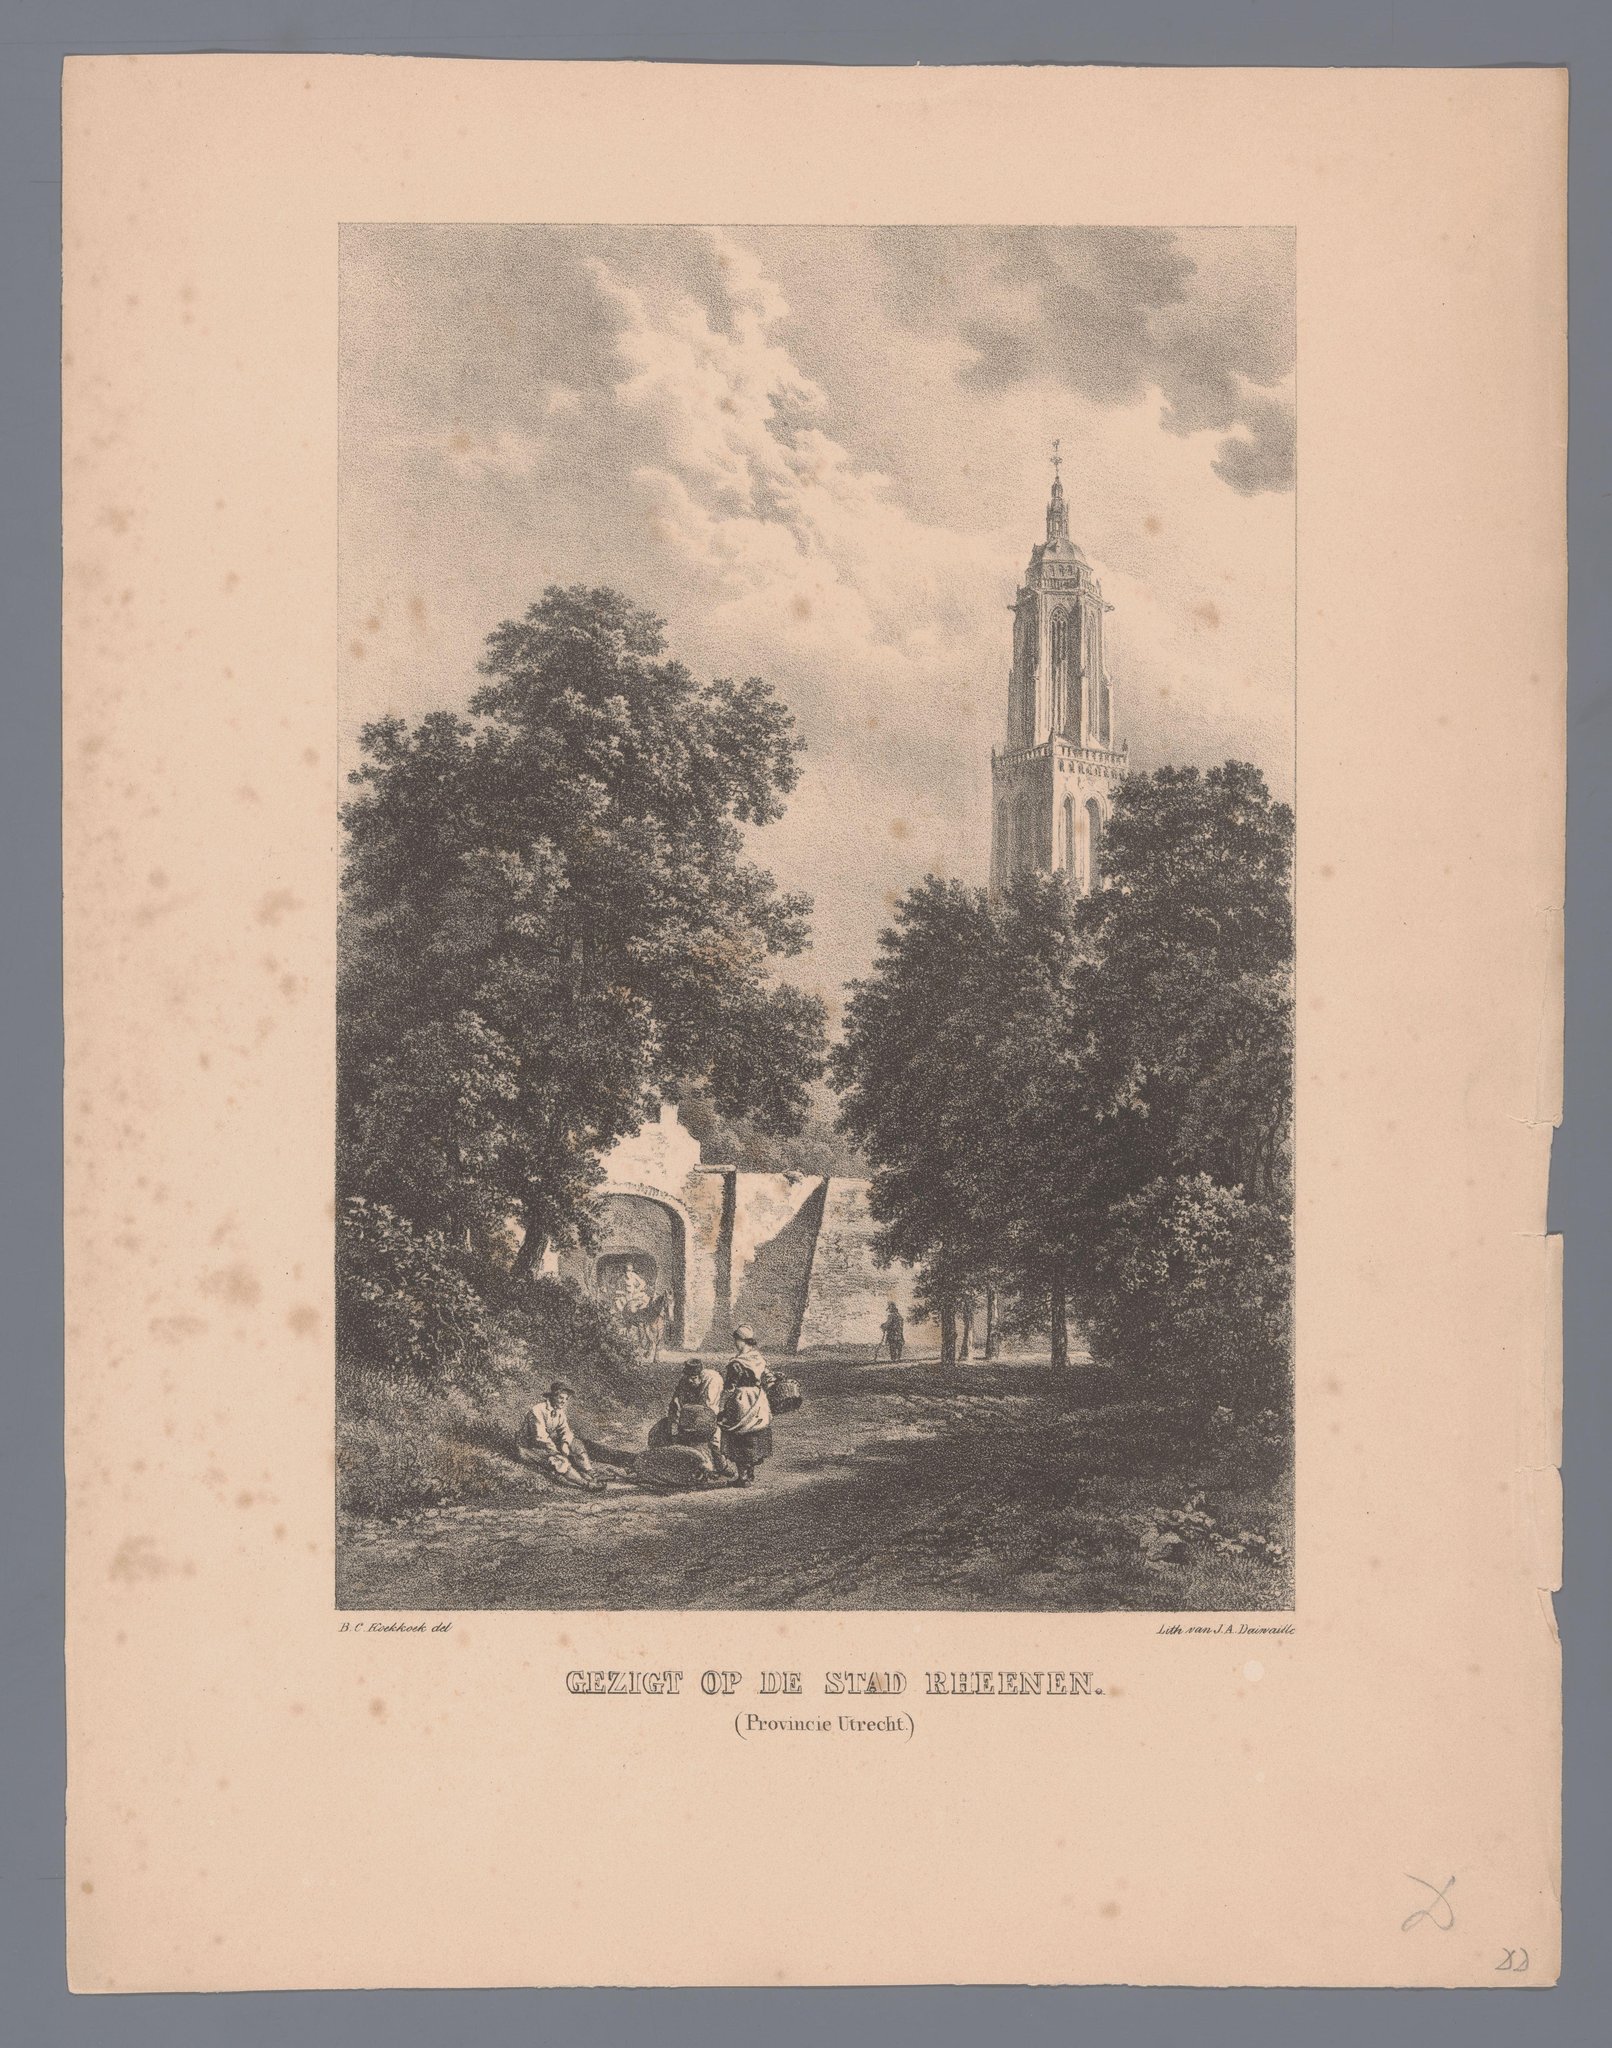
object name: print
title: Vues Pittoresques du Royaume des Pays-Bas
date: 1831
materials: paper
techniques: lithograph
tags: church (exterior), public road in village (+ city(-scape) with figures, staffage), rhenen